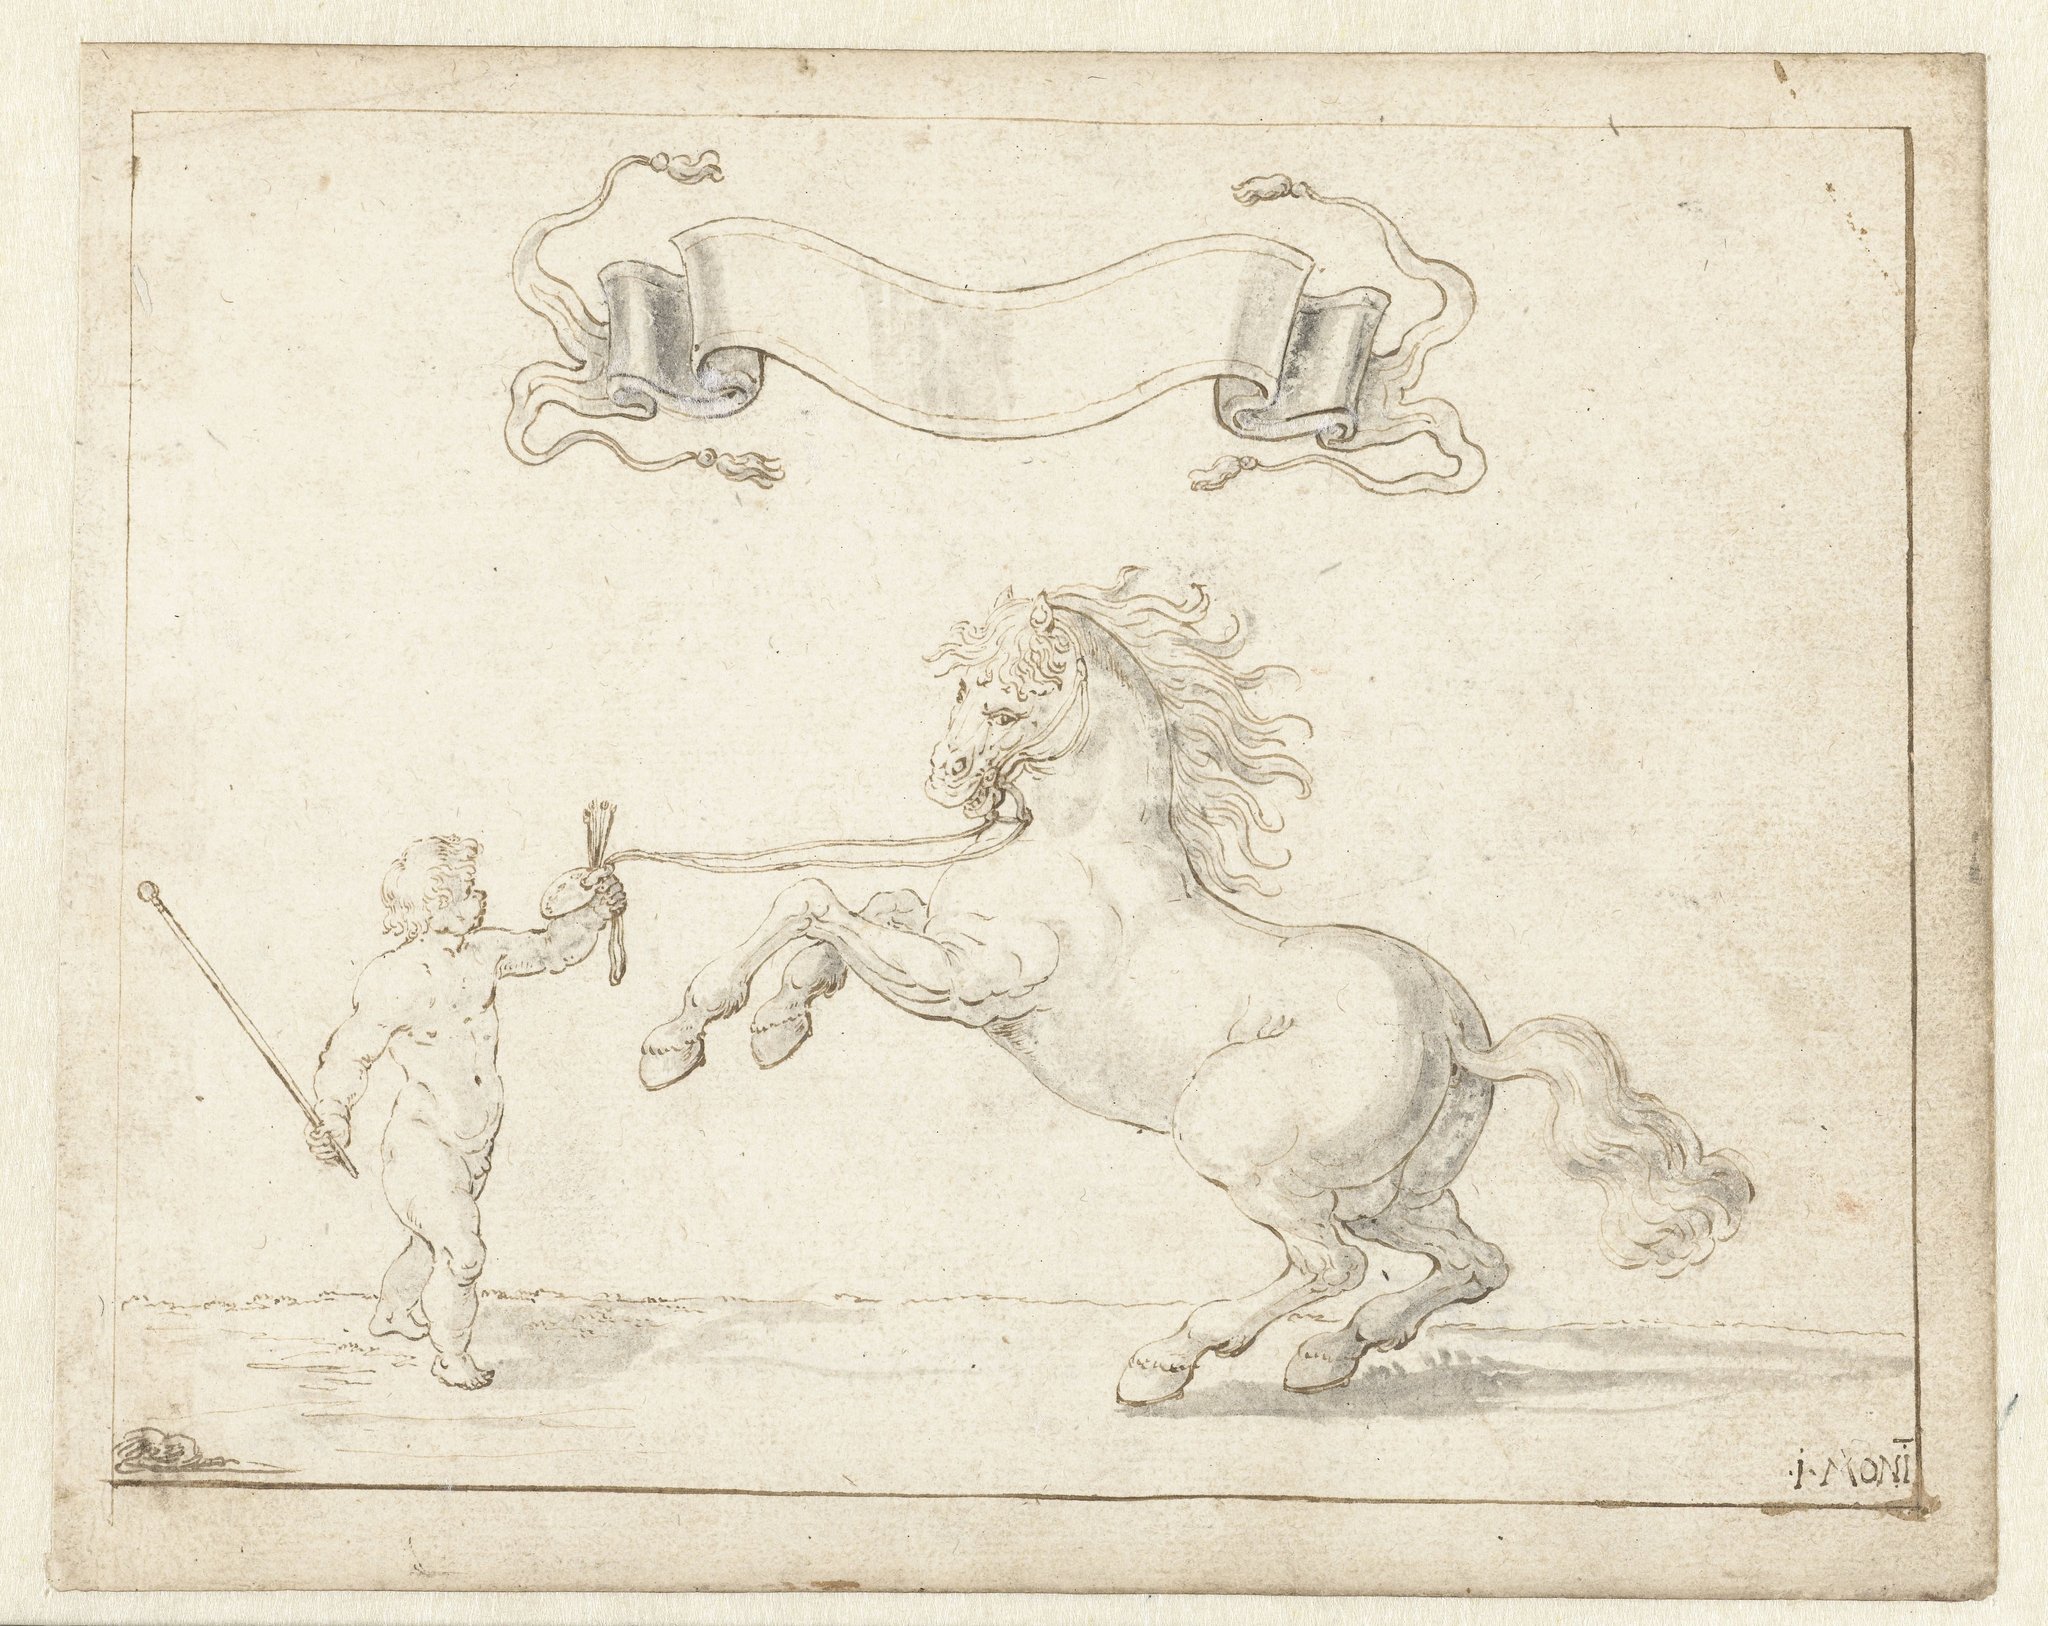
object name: drawing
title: Naakt jongetje met schildersattributen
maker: jan moninckx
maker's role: draughtsman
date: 1600-1699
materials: ink, paper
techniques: brush, pen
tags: 'pictura', symbolic representations, allegories and emblems ~ painting; 'pittura' (ripa), boy (child between toddler and youth), tools, implements of painter, taming of wild horses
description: Allegorische voorstelling: een naakt jongetje met schildersattributen, palet, penselen en schildersstok, dat een steigerend paard aan de leidsels in bedwang houdt.